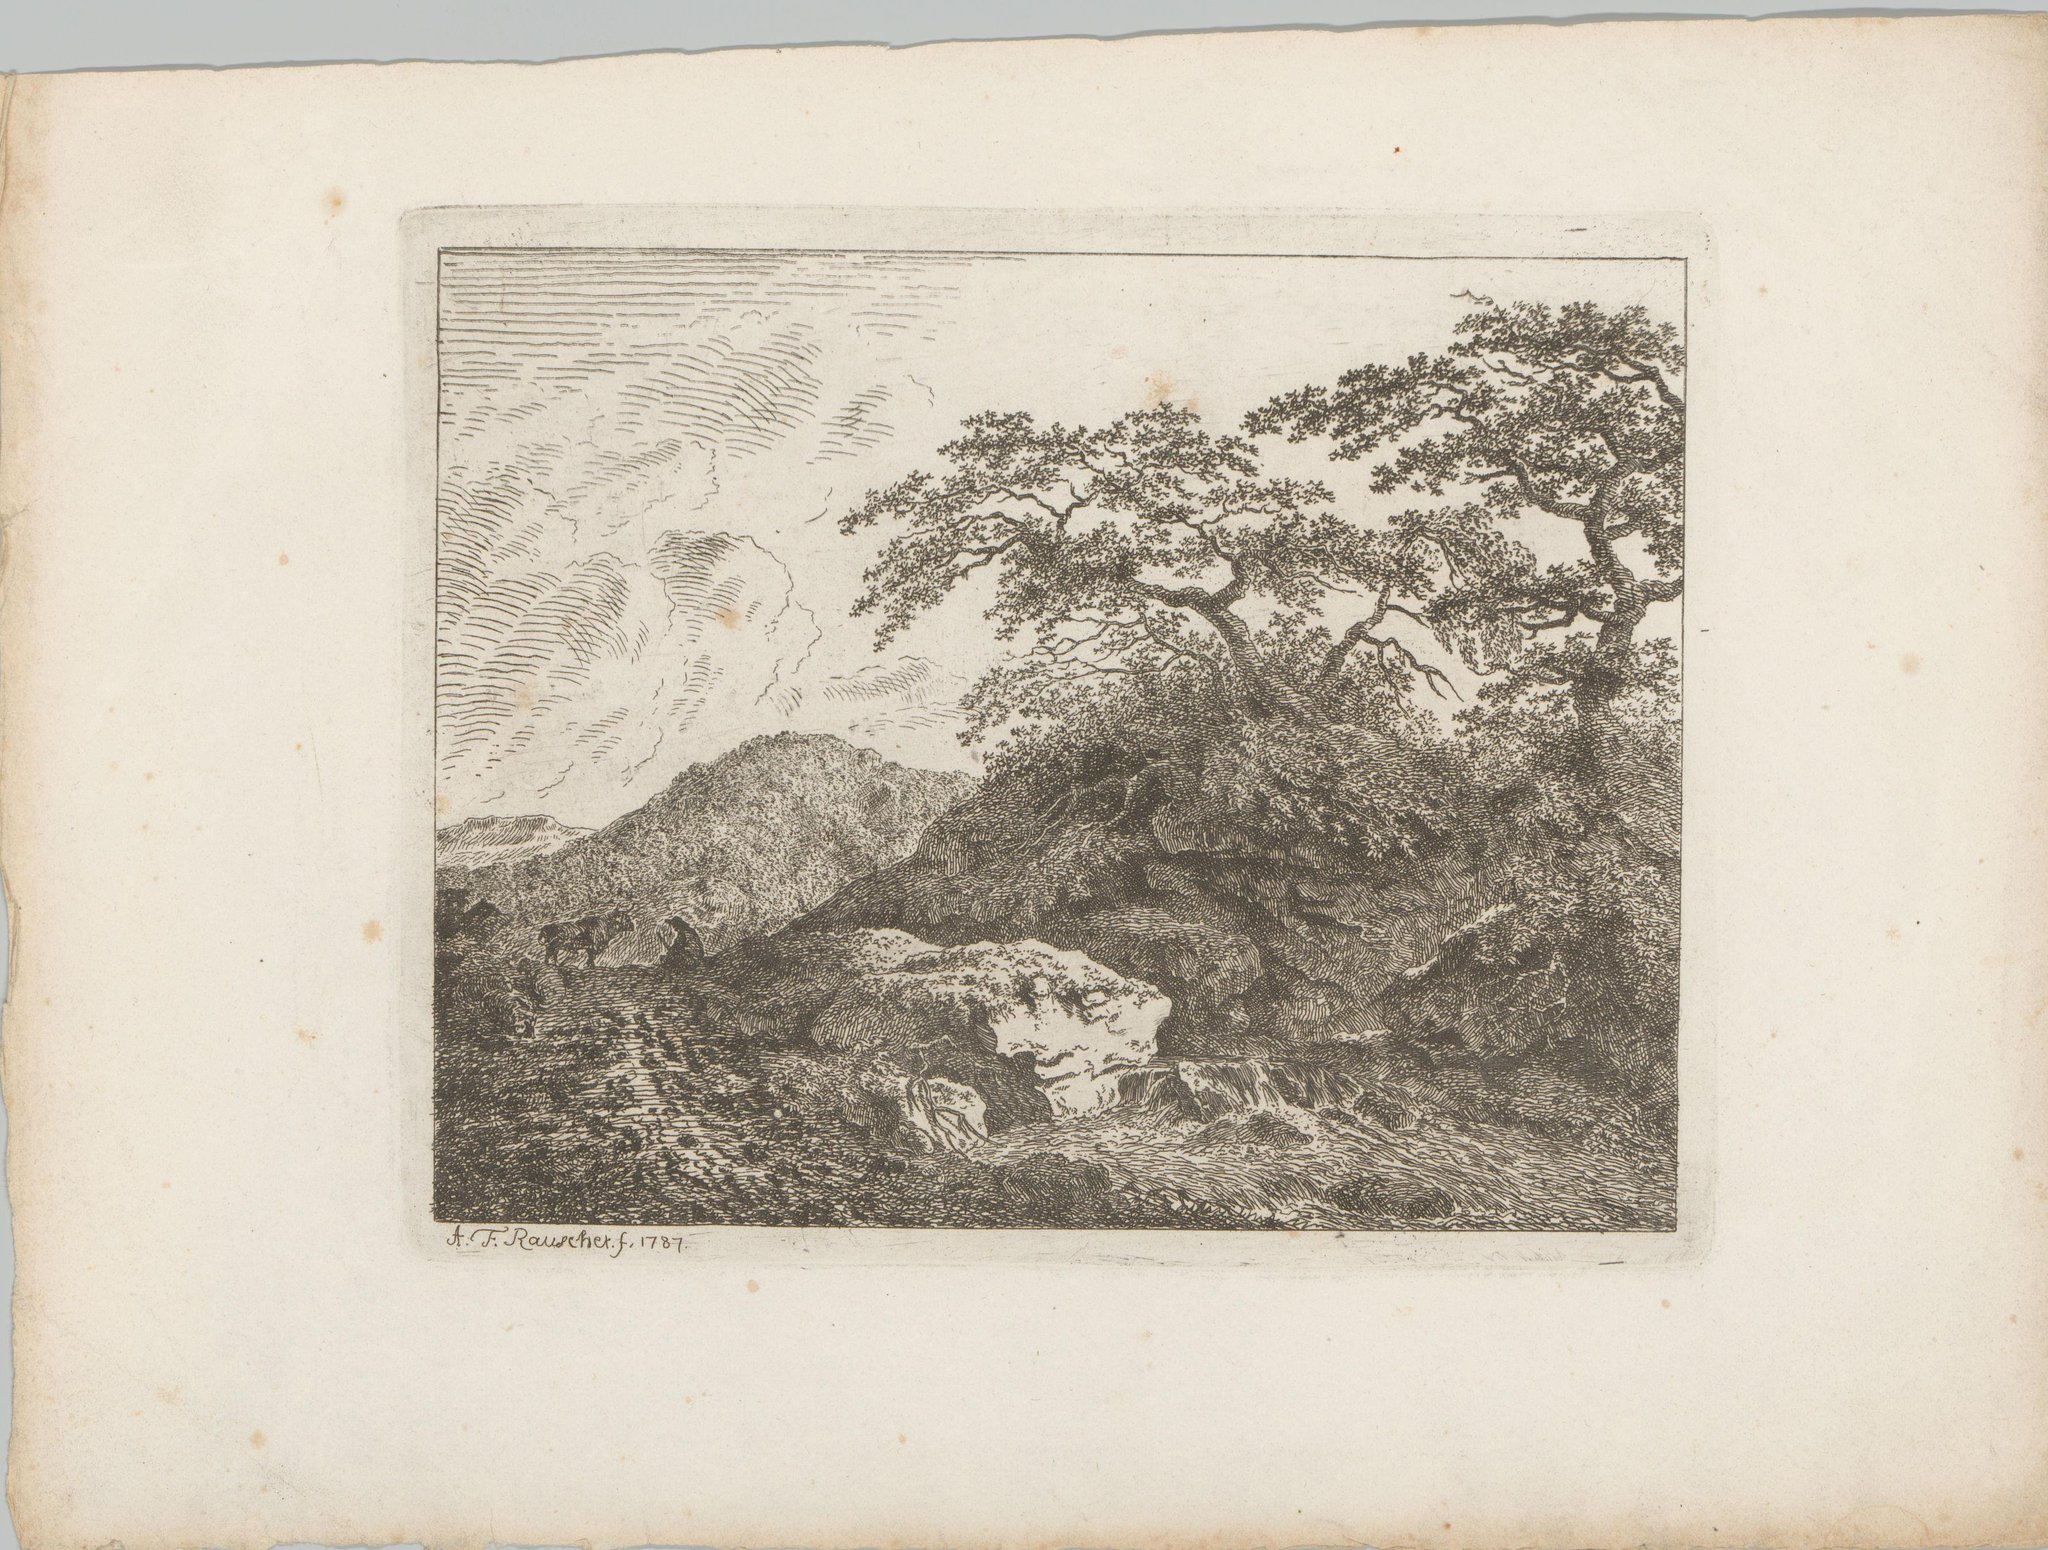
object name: print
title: Landschap met beek en op de achtergrond een man en een stier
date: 1787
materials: paper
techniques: etching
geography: leipzig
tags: landscapes, forest, wood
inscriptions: collector's mark: Lugt 4807, collector's mark: Lugt 2760, collector's mark: Lugt 2228